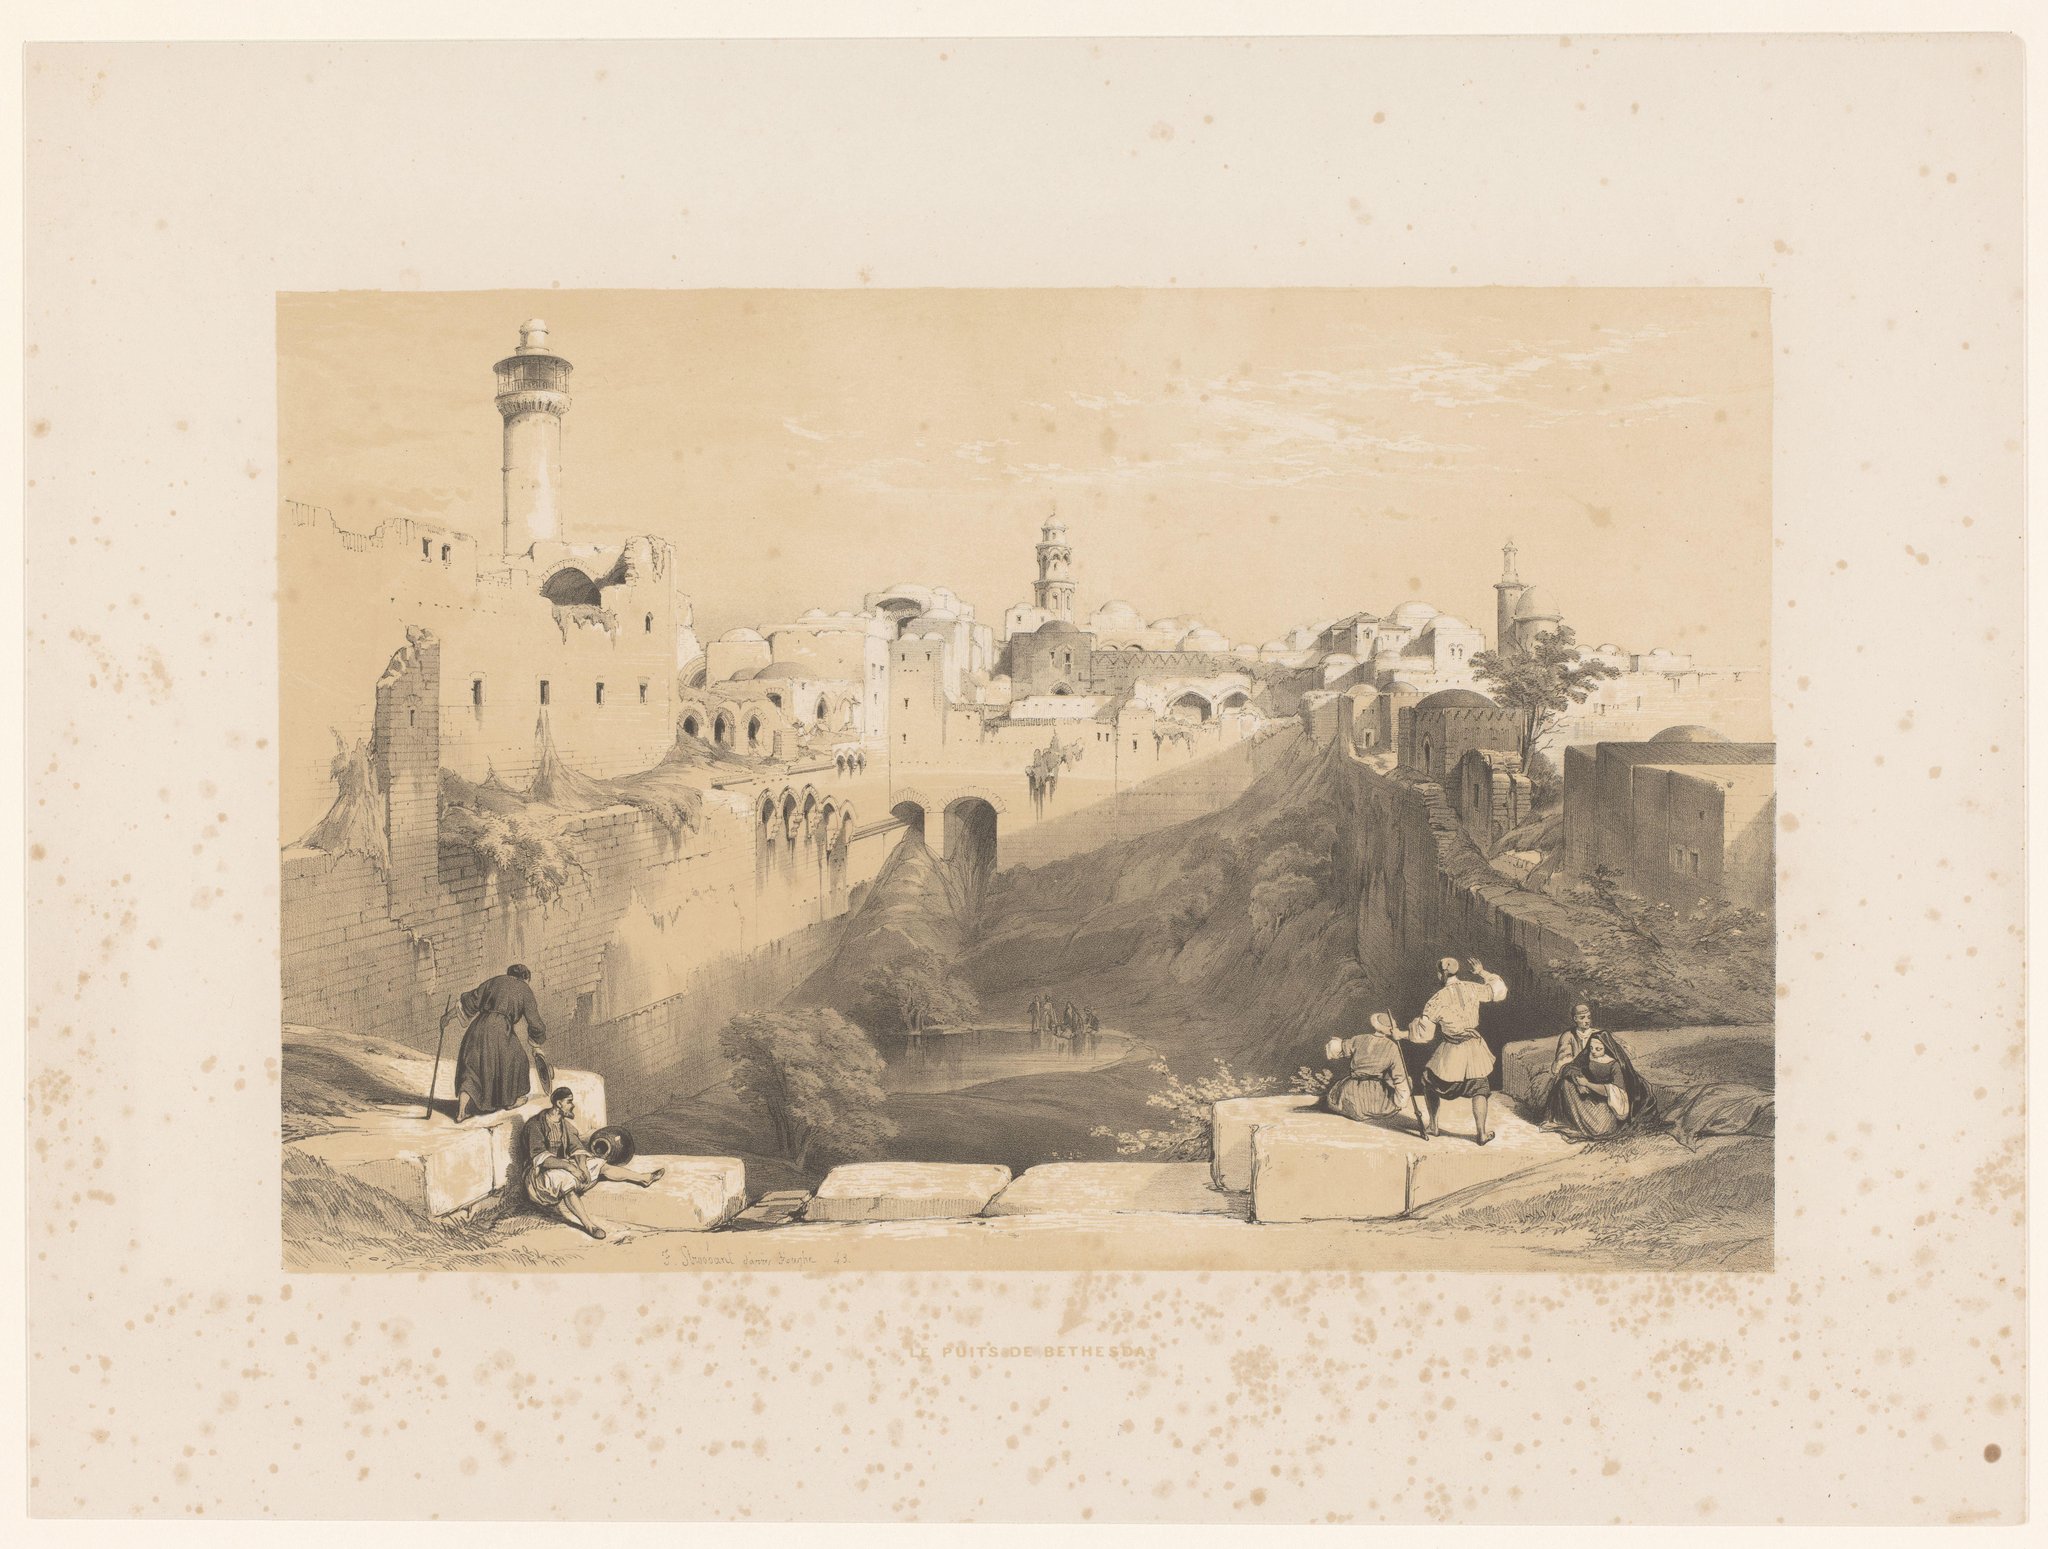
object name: print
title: Gezichten en monumenten van het Heilige Land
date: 1852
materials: paper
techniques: tone lithography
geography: brussels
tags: the sick try to reach the water of the pool of bethesda, city-walls, city-view in general; 'veduta' (+ city(-scape) with figures, staffage)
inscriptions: collector's mark: Lugt 2228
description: Jules Géruzet maakt in 1852 een heruitgave van het Belgische werk 'La terre sainte. Vues et monuments recueillis par David Roberts de l'Académie de Londres' dat tussen 1843-1845 wordt gedrukt door J. Lots en waarvan de prenten, op verzoek van de Société des Beaux-Arts, door Ghemar en Stroobant worden uitgevoerd naar werken van Haghe.